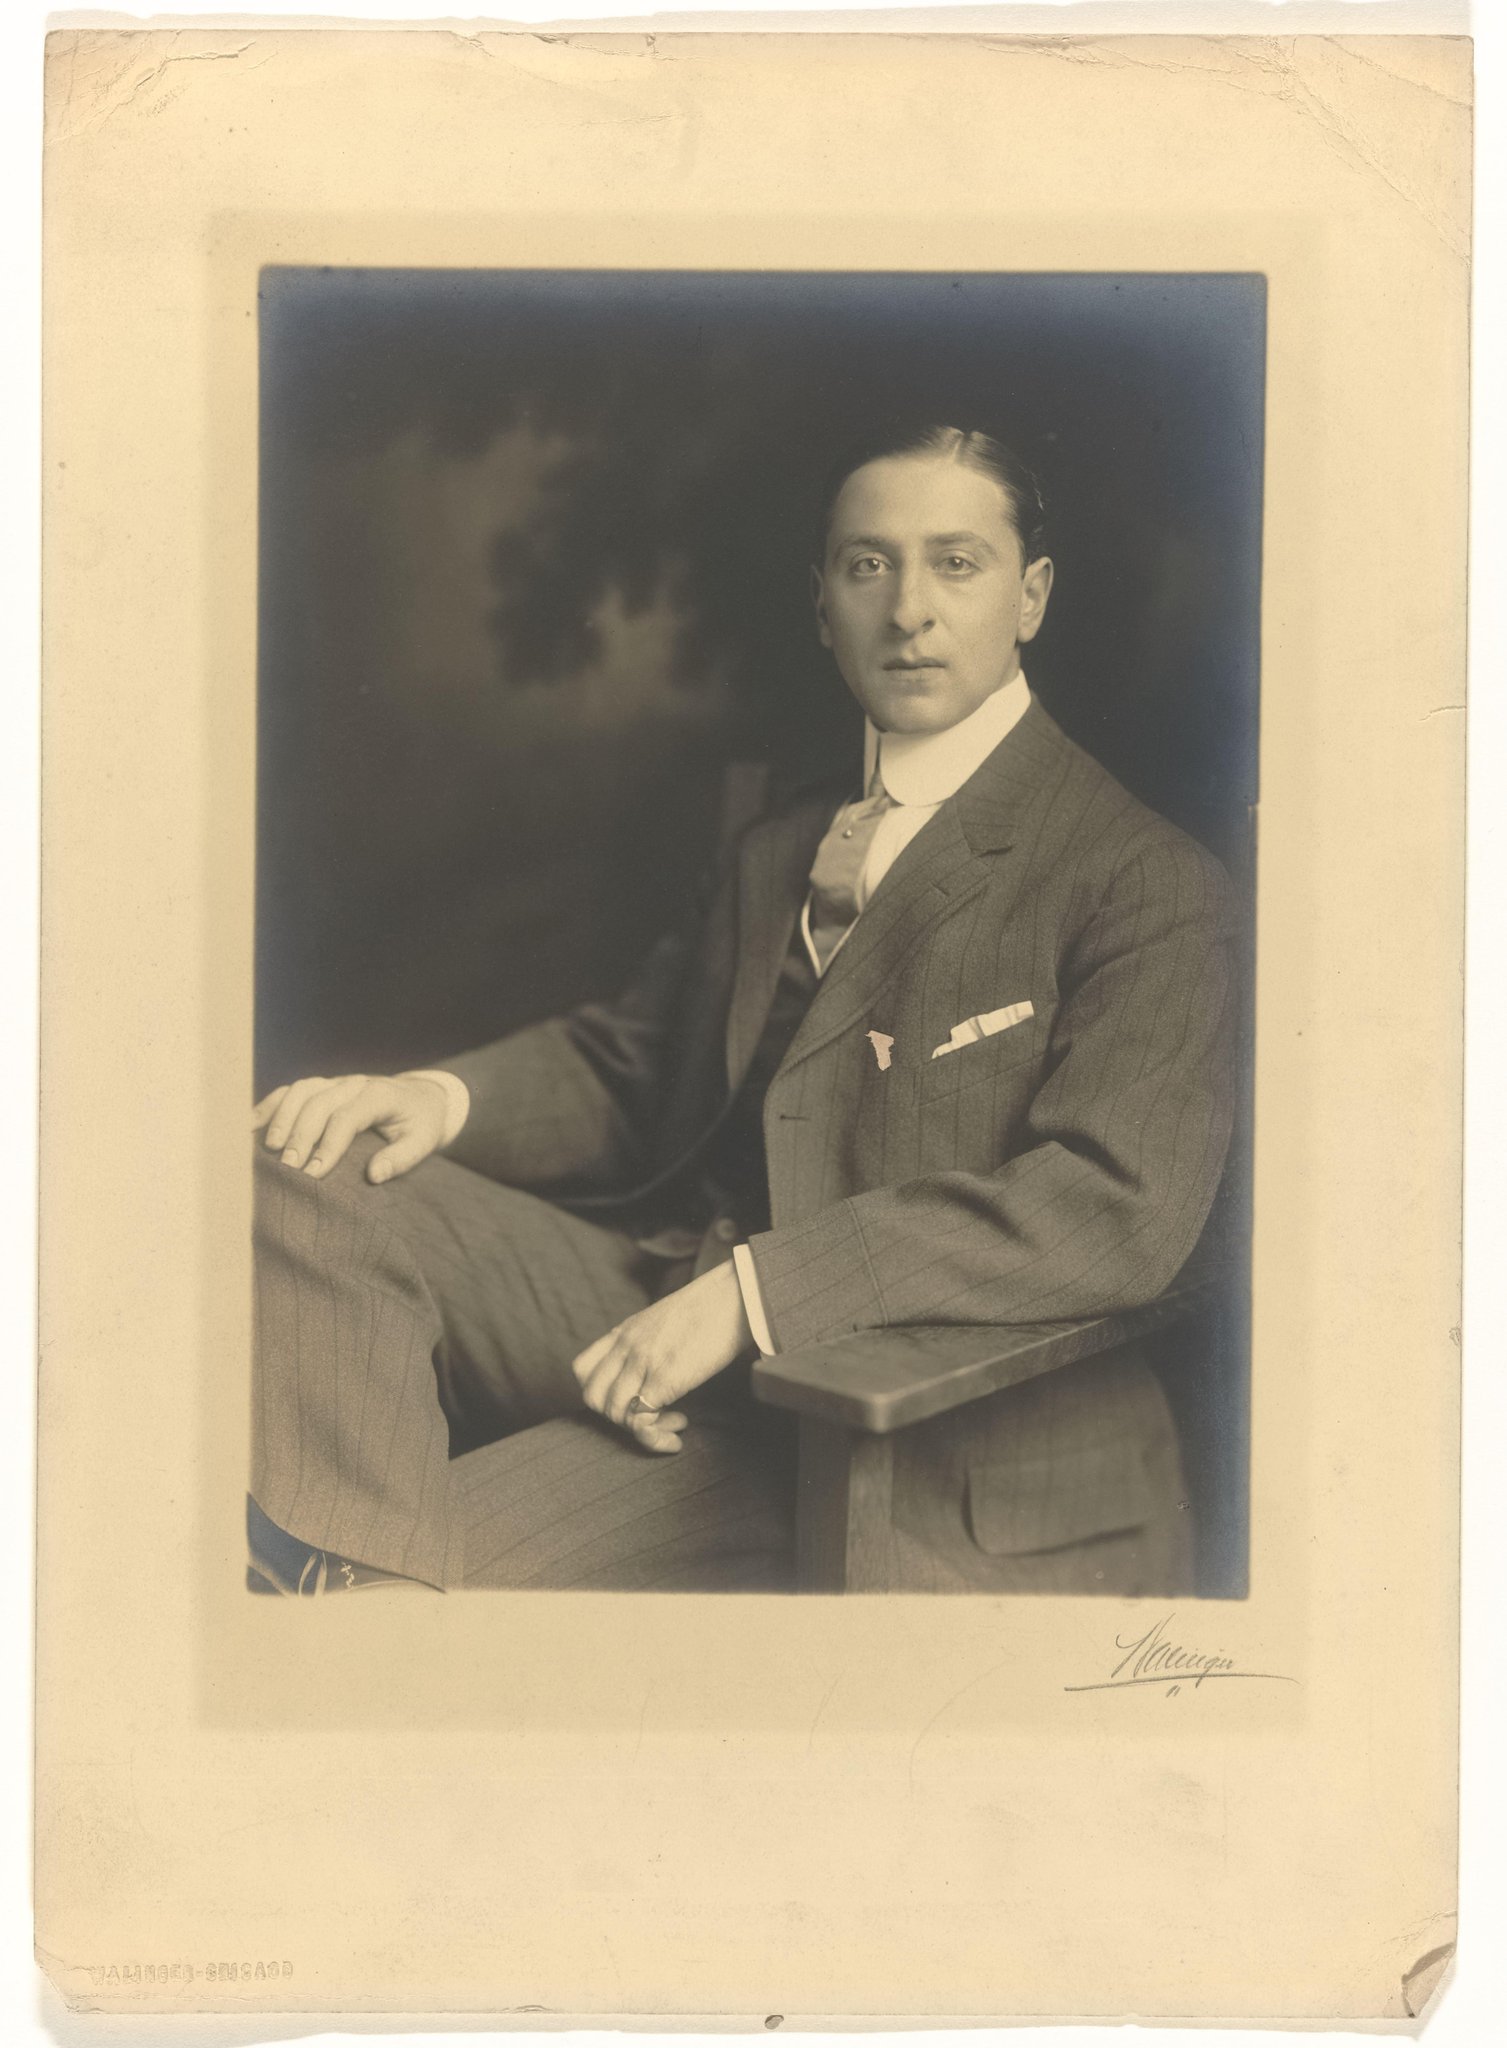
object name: photograph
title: Arthur Moos, gezeten in een stoel, in civiele kleding, 1905-1922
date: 1905-1922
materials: photographic support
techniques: gelatin silver print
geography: chicago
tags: arthur moos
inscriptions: company name: ‘Walinger-Chicago’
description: Arthur Moos, gezeten in een stoel, in civiele kleding.